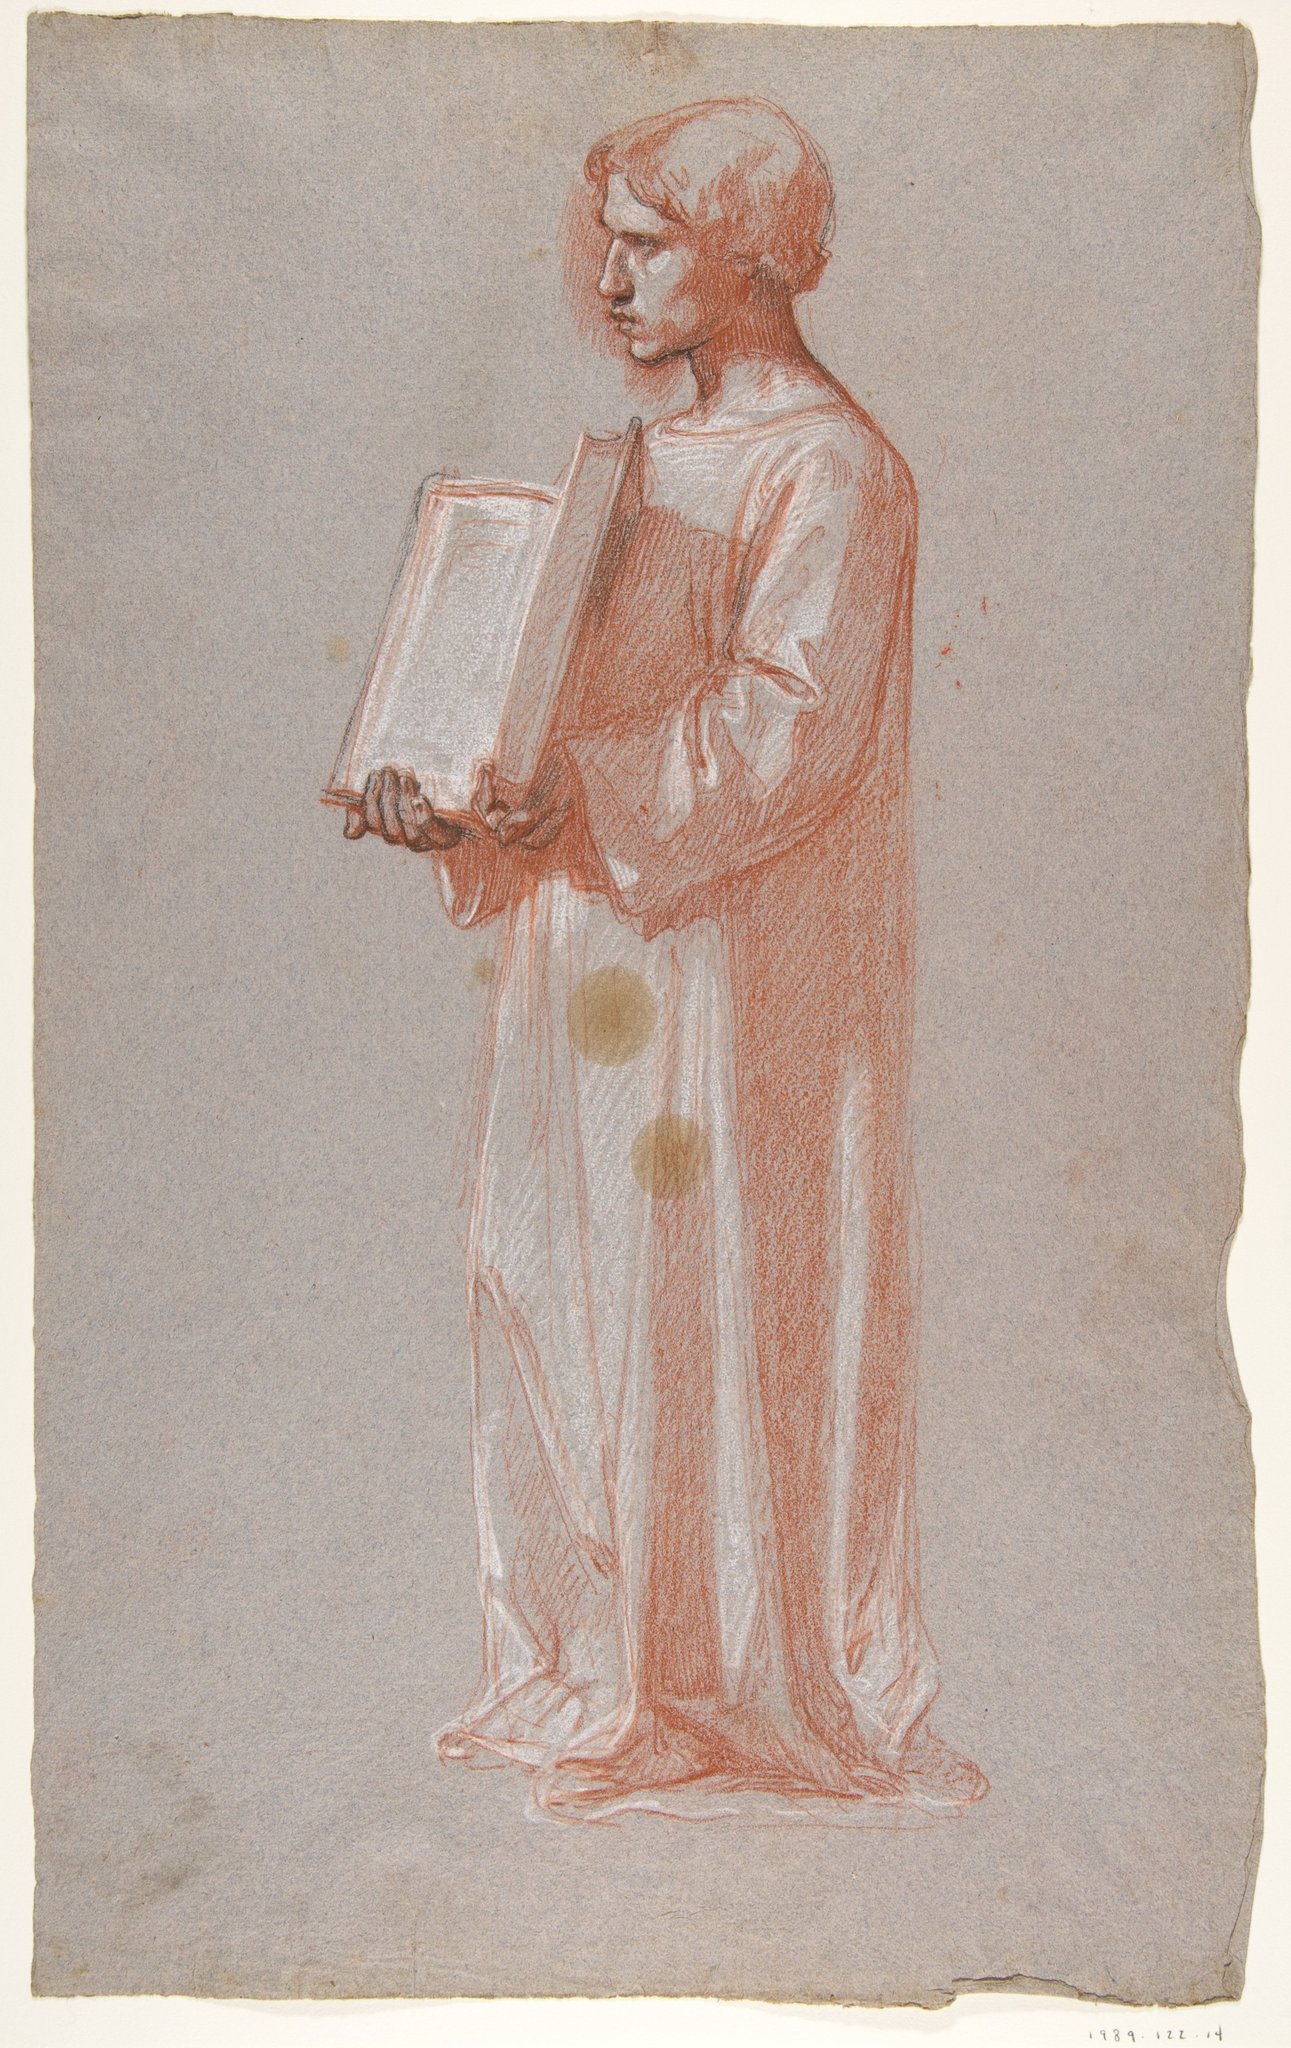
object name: drawing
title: Acolyte with Open Book (middle register; study for wall paintings in the Chapel of Saint Remi, Sainte-Clotilde, Paris, 1858)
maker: isidore pils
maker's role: artist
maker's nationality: french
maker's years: 1813-1875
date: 1801-1900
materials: chalk, paper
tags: books,men